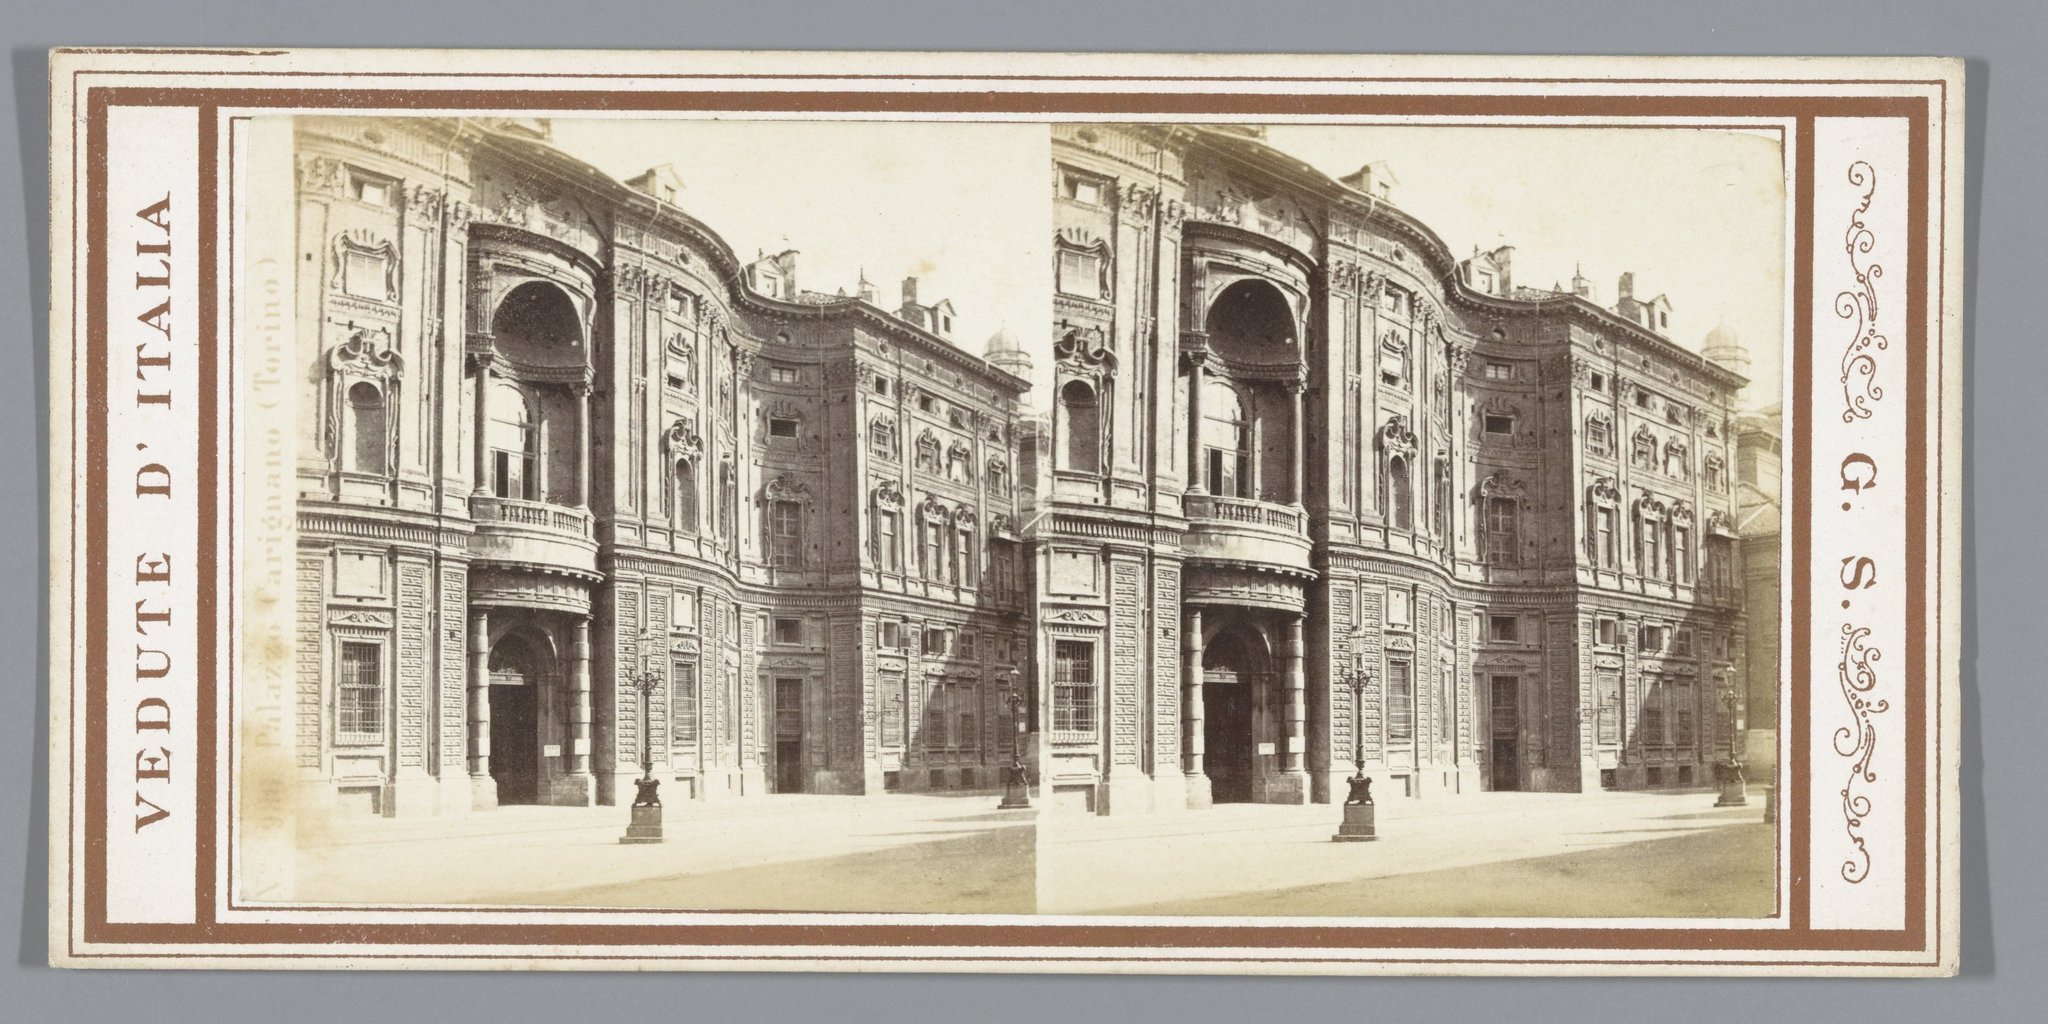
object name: stereograph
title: Palazzo Carignano (Torino)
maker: giorgio sommer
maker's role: fotograaf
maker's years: 1834-1914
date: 1860-1880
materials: cardboard, photographic support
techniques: albumen print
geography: turin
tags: palace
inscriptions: number: ‘No. 986.’